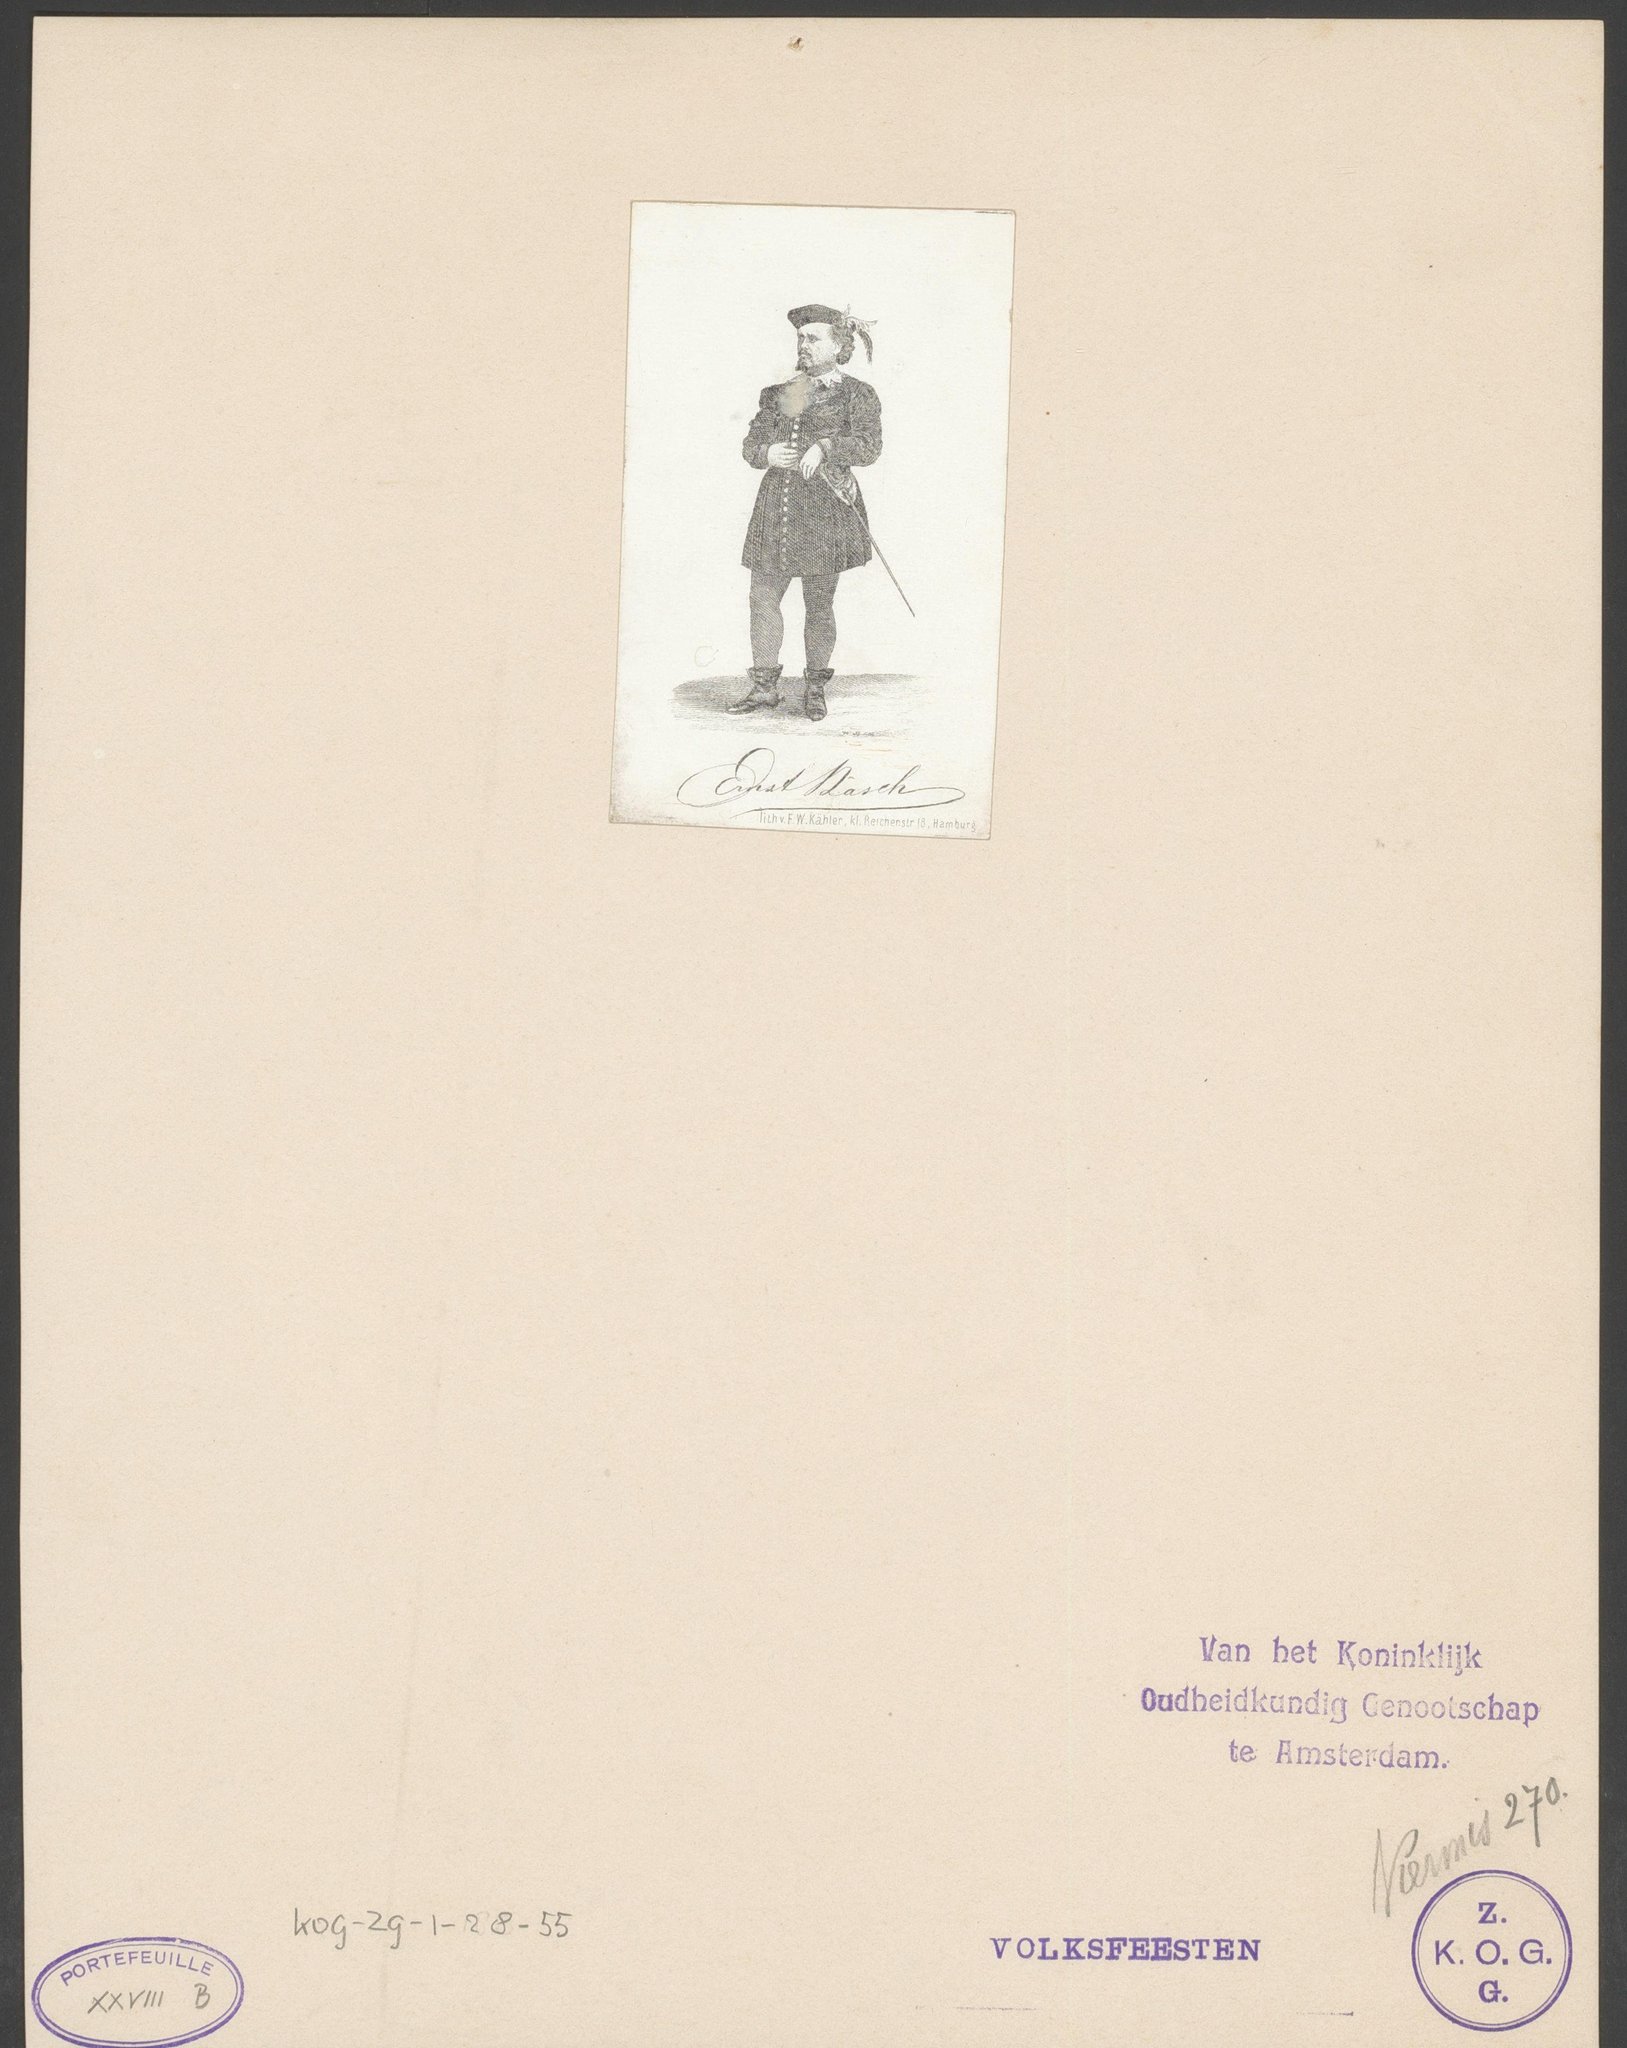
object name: print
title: Portret van een onbekende artiest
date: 1863-1907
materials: paper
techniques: lithograph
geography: hamburg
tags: the show; fair and circus performers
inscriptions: stamp: ‘Van het Koniklijk Oudheidkundig Genootschap te Amsterdam’, collector's mark: Lugt 1641, stamp, stamp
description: Onderwerpsrubrieken binnen de Atlas Zeden en Gewoonten: Zeden en Gewoonten in Engeren Zin. Volksleven. Volksfeesten. Circusmenschen, dierentemmers, acrobaten, goochelaars, en dergelijken.